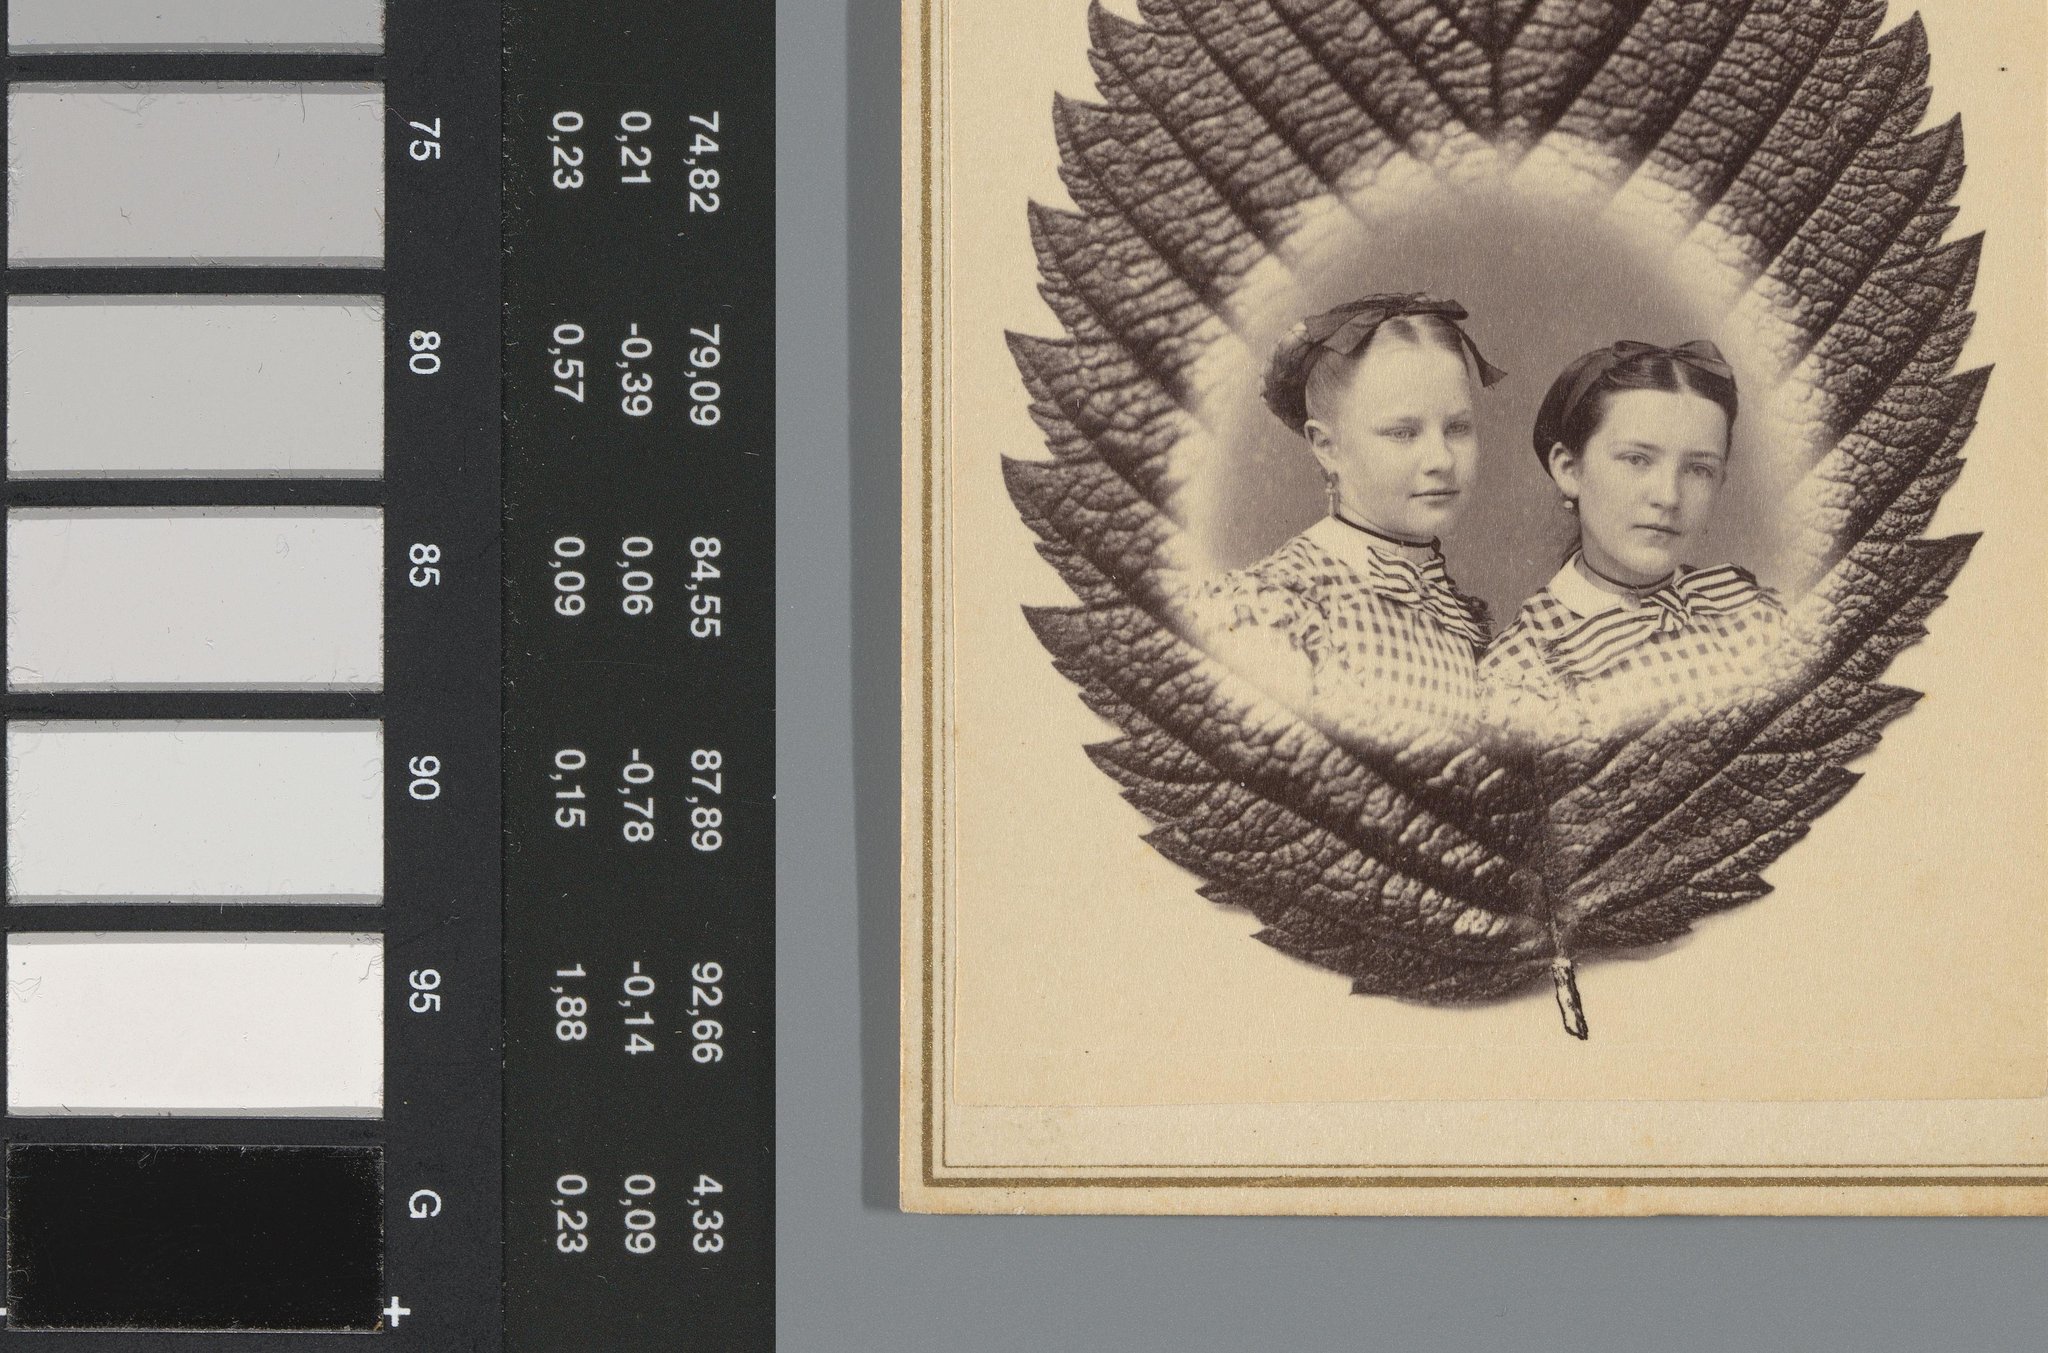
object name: carte de visite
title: Portret van twee meisjes, fotomontage in boomblad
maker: s.e. tubbs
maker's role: fotograaf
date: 1865-1875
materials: cardboard, paper, photographic support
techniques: albumen print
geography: seneca county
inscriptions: inscription: ‘G. S. TUBBS, SON & CO., / Photographers, FARMER VILLAGE, / Seneca Co., / N. Y., / S. E. TUBBS, Operator. / All negatives preserved.’